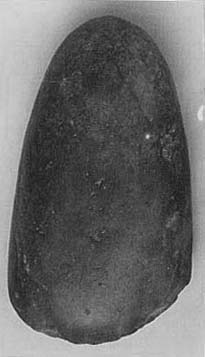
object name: hatchet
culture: french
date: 1902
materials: jade